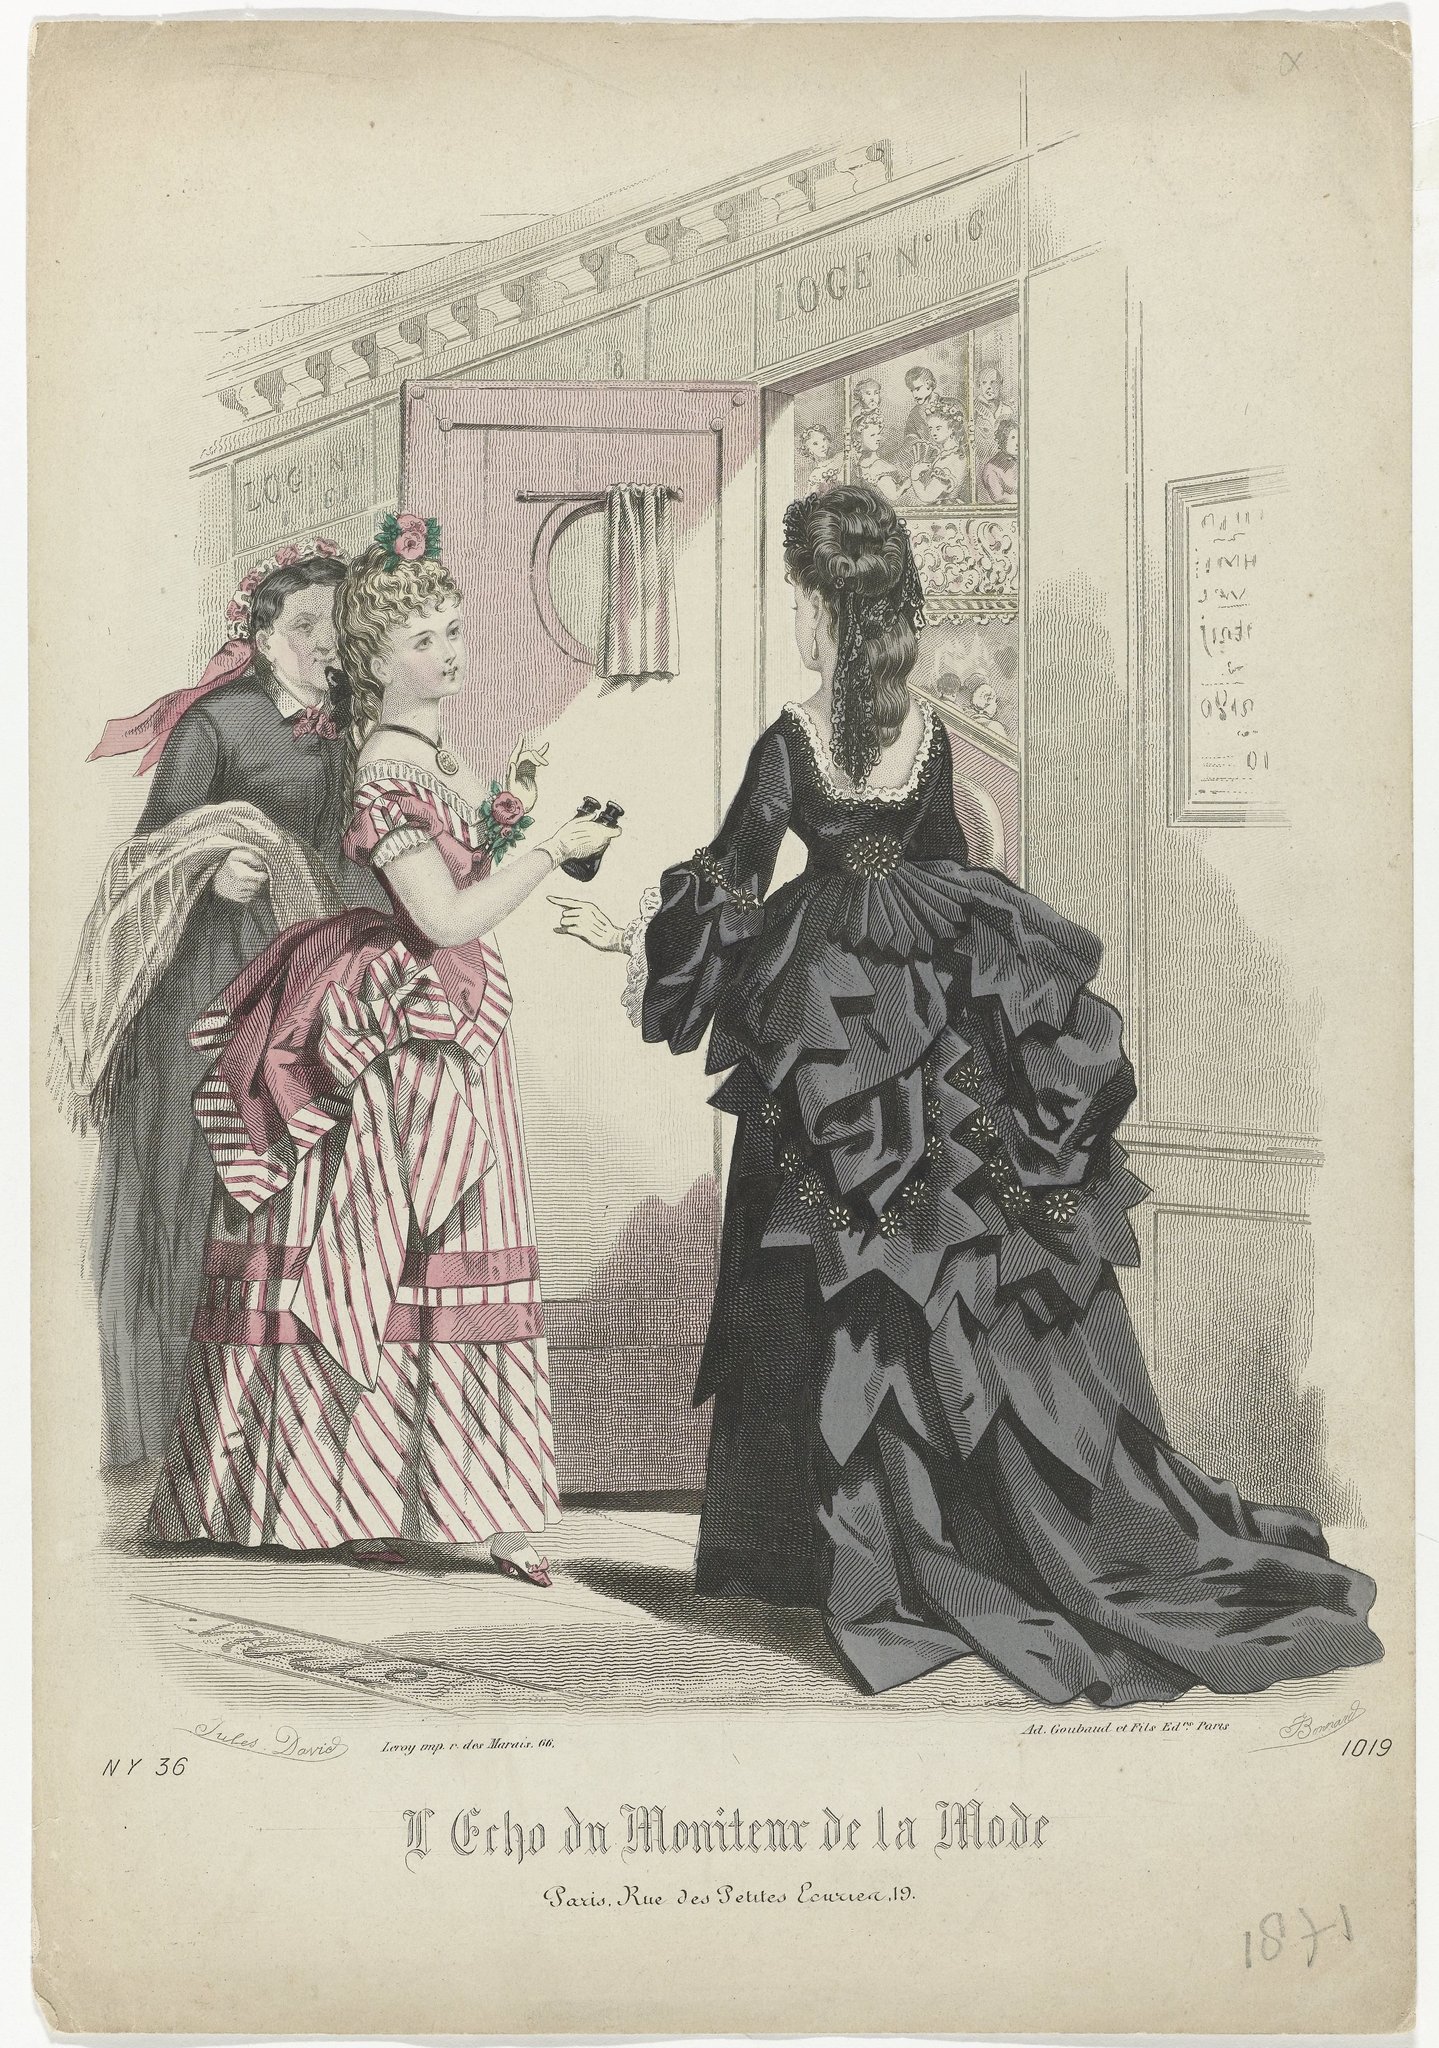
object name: fashion print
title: L'Echo du Moniteur de la Mode, 1871, NY 36, No. 1019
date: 1871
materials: paper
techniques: engraving, hand coloring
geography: paris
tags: corsage (+ women's clothes), clothing for the upper part of the body (+ women's clothes), pendant, trinket, 'breloque' (+ women's clothes), boxes, loges ~ theatre, etc., head-gear (+ women's clothes), fashion plates, shoes, sandals (+ women's clothes), gloves, mittens, etc. (+ women's clothes), dress, gown (+ women's clothes), binoculars, spy-glass, etc.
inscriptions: address: ‘Paris, Rue des Petites Ecurier, 19.’, title: ‘L'Echo du Moniteur de la Mode’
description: Drie vrouwen bij de ingang van een theaterloge, gekleed in avondjaponnen. De vrouw met een verrekijker in de hand, draagt een roze gestreepte japon met korte mouwen en queue en muiltjes. De vrouw op de rug gezien, draagt een zwarte japon met vierkante halsuitsnijding op de rug en sleep. Prent uit het modetijdschrift L'Echo du Moniteur de la Mode (1843 (?)-1888)